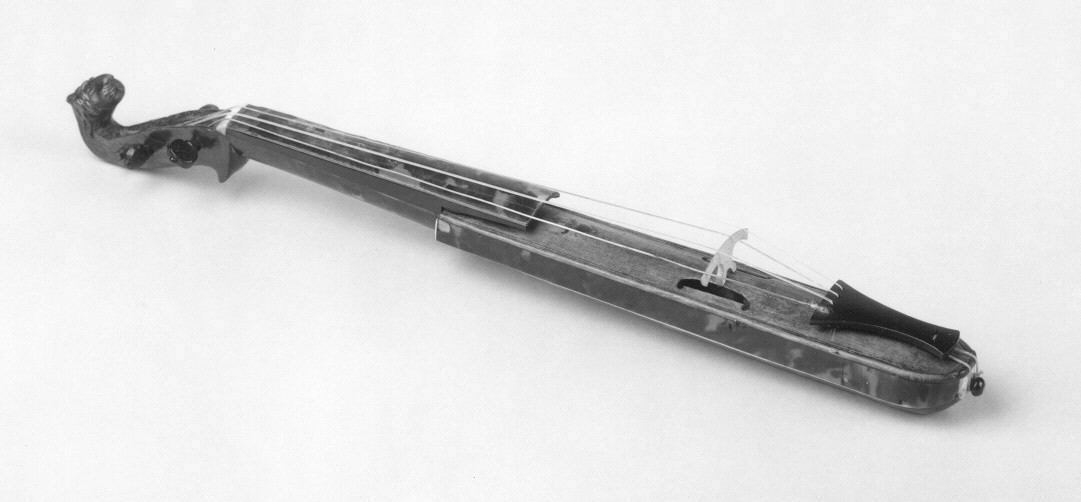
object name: pochette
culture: german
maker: matthias wörle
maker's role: maker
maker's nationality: german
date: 1601-1700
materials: shell, wood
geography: germany